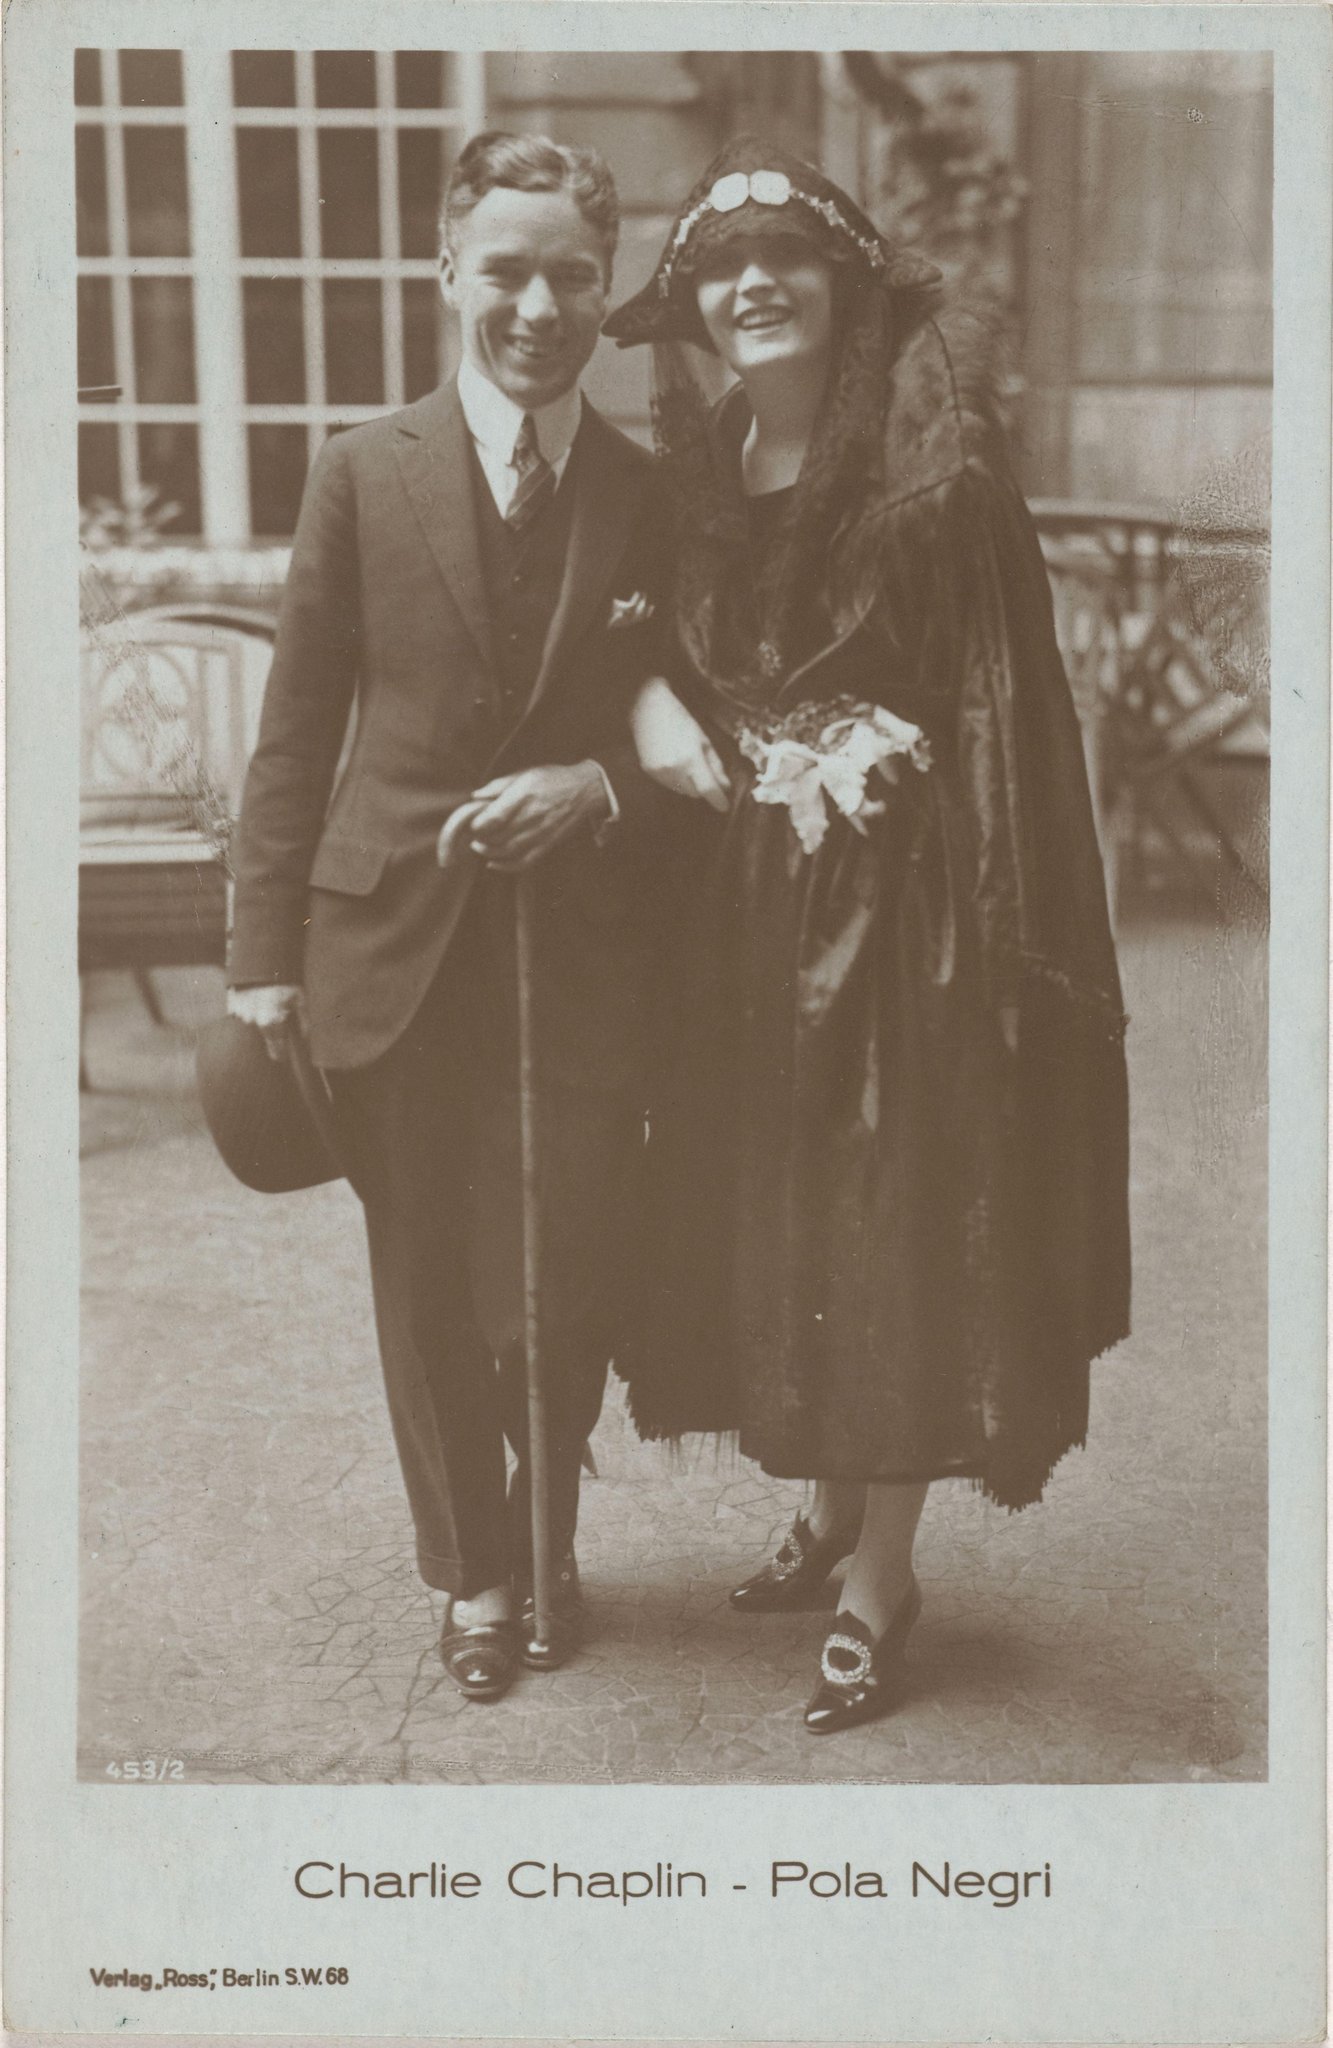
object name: photograph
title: Charlie Chaplin-Pola Negri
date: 1900-1950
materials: photographic support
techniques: gelatin silver print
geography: berlin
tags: acteur, charlie chaplin